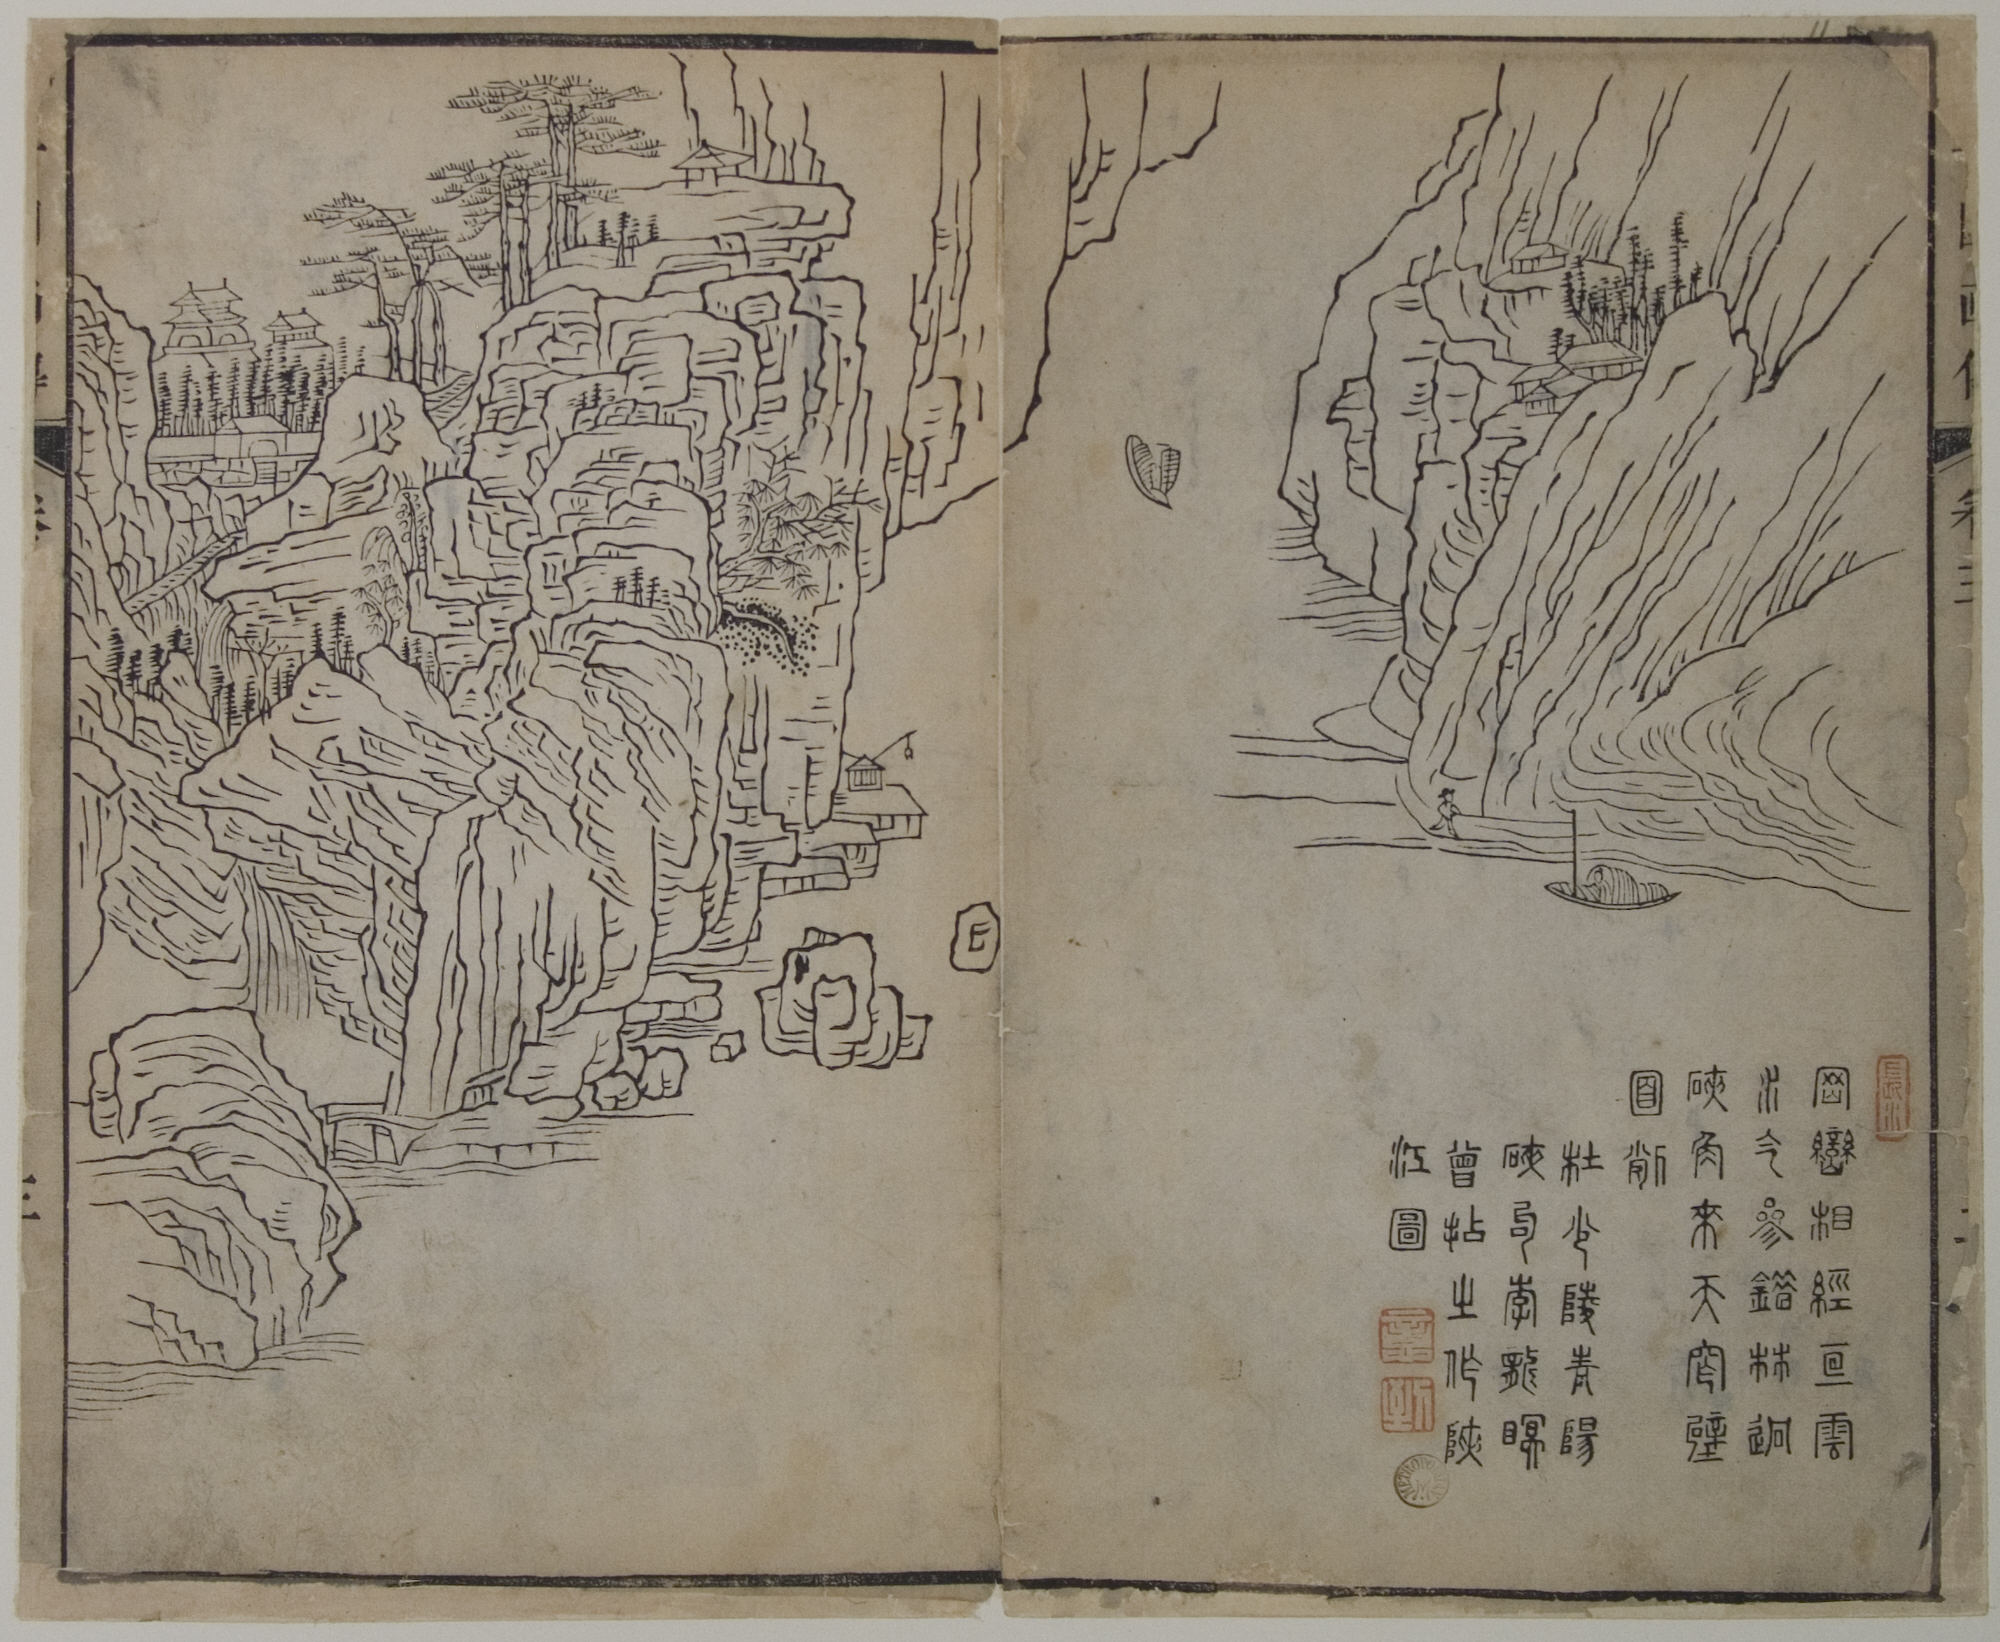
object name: print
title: Page from the Mustard Seed Garden Manual of Painting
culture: chinese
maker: wang gai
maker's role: artist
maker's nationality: chinese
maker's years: 1645-1710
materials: ink, paper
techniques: woodblock print